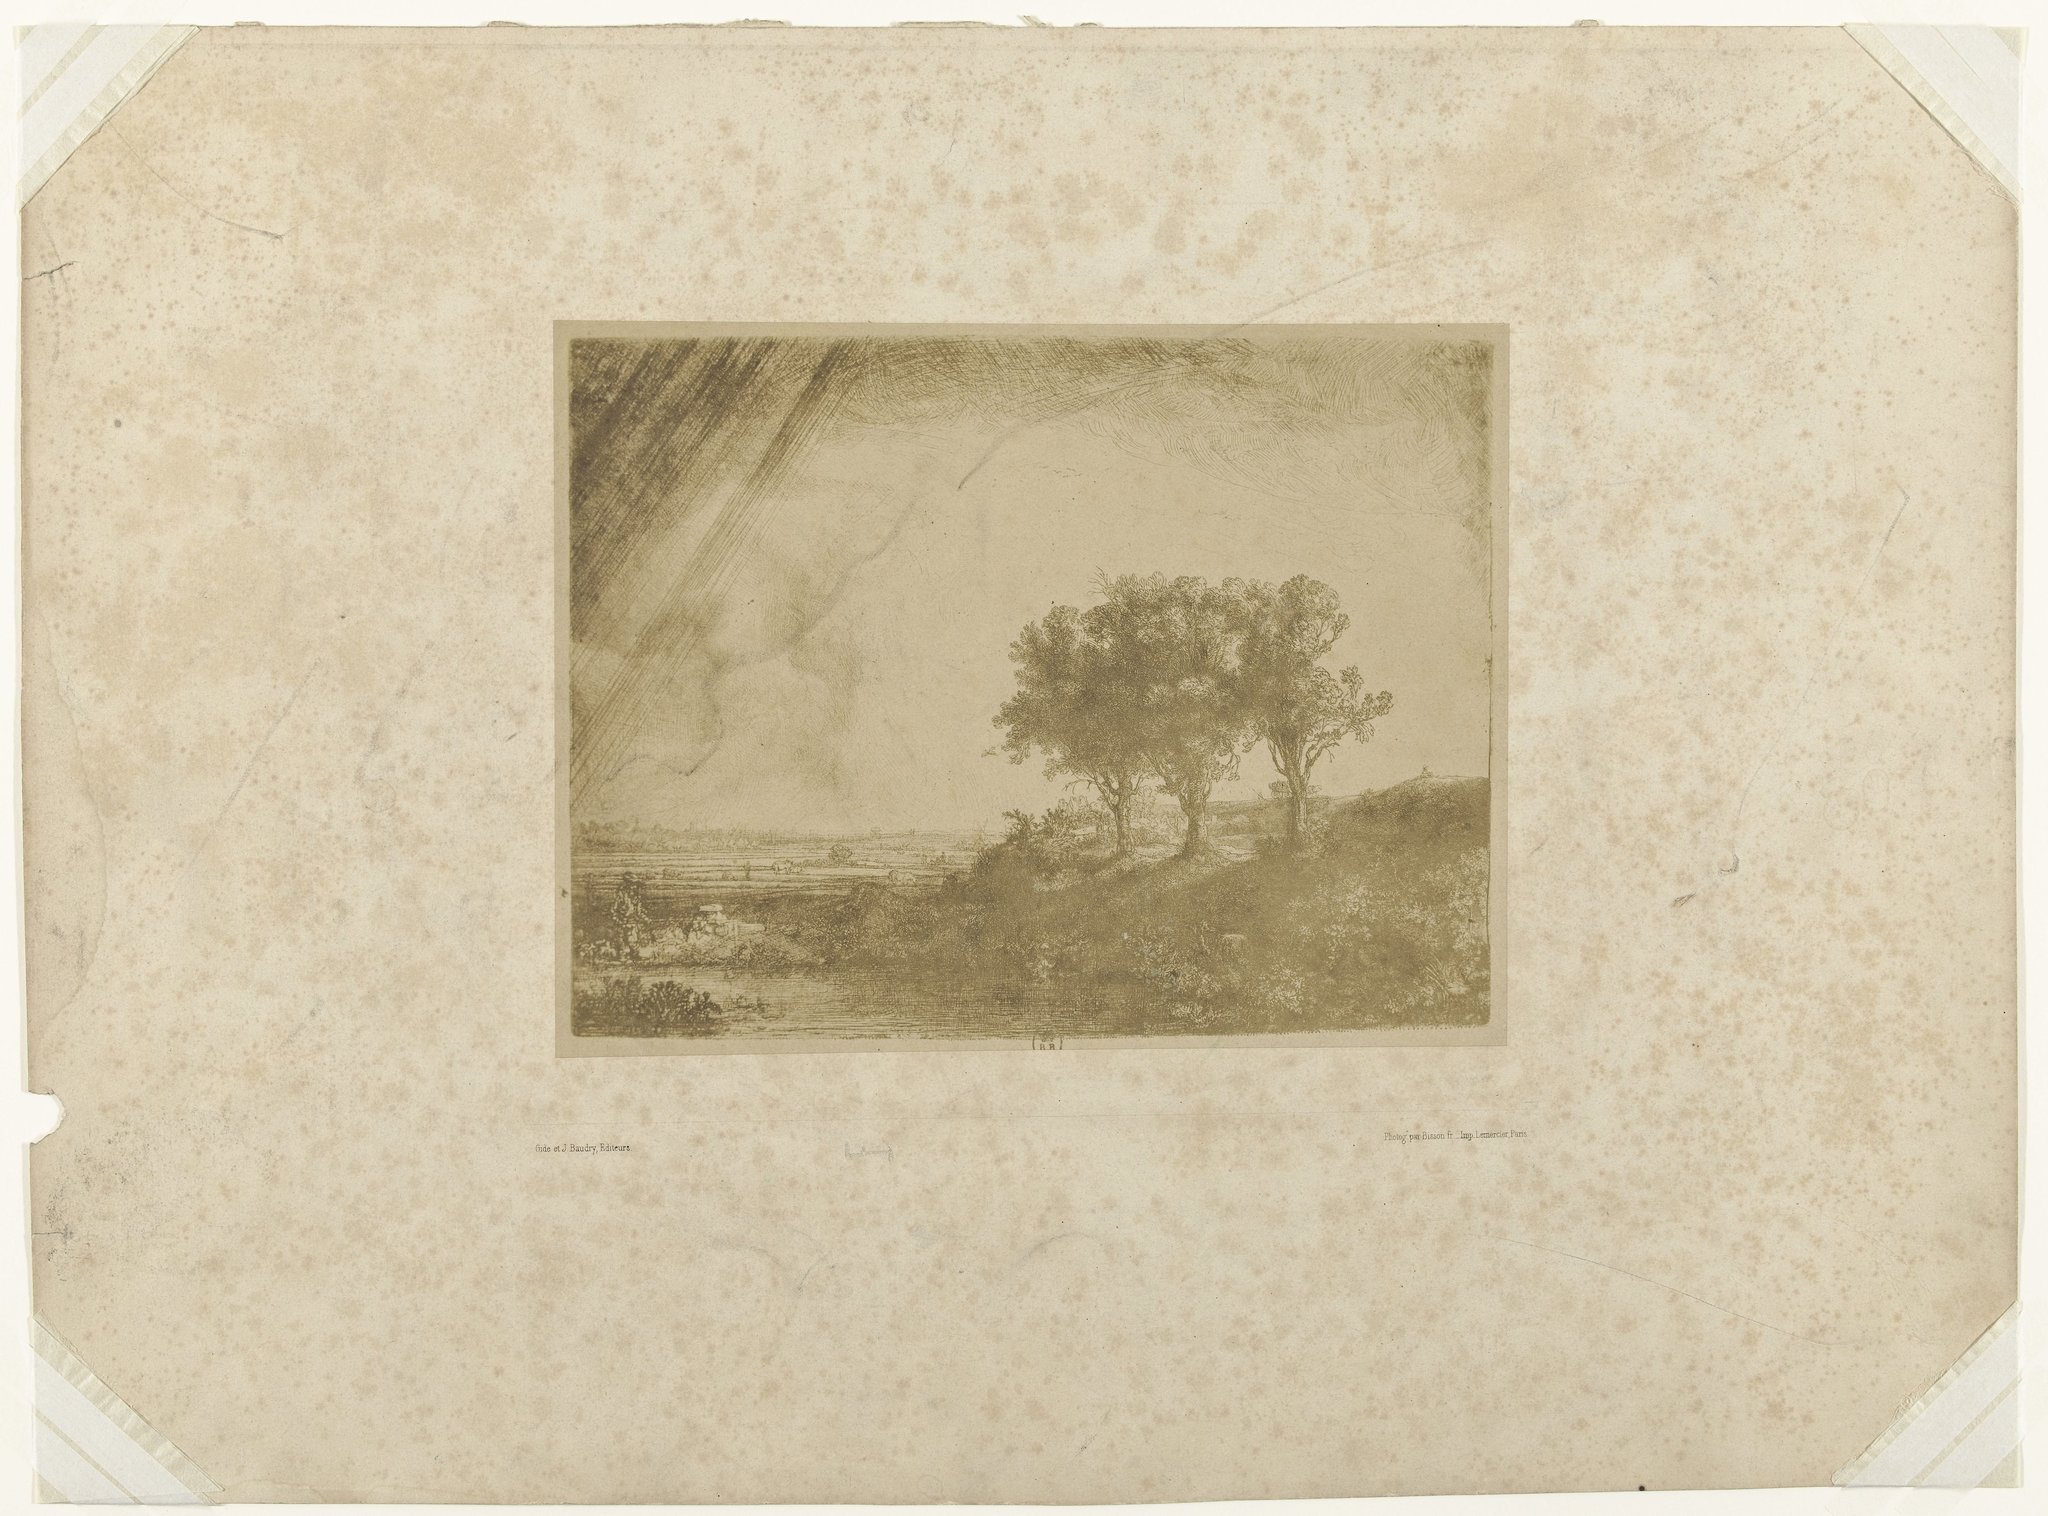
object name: photograph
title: De drie bomen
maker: joseph rose lemercier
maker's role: printer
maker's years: 1803-1887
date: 1854-1858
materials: cardboard, photographic support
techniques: salted paper print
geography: france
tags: swamps and polders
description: Foto-reproductie van een ets van Rembrandt, 'De drie bomen' (B. 212)